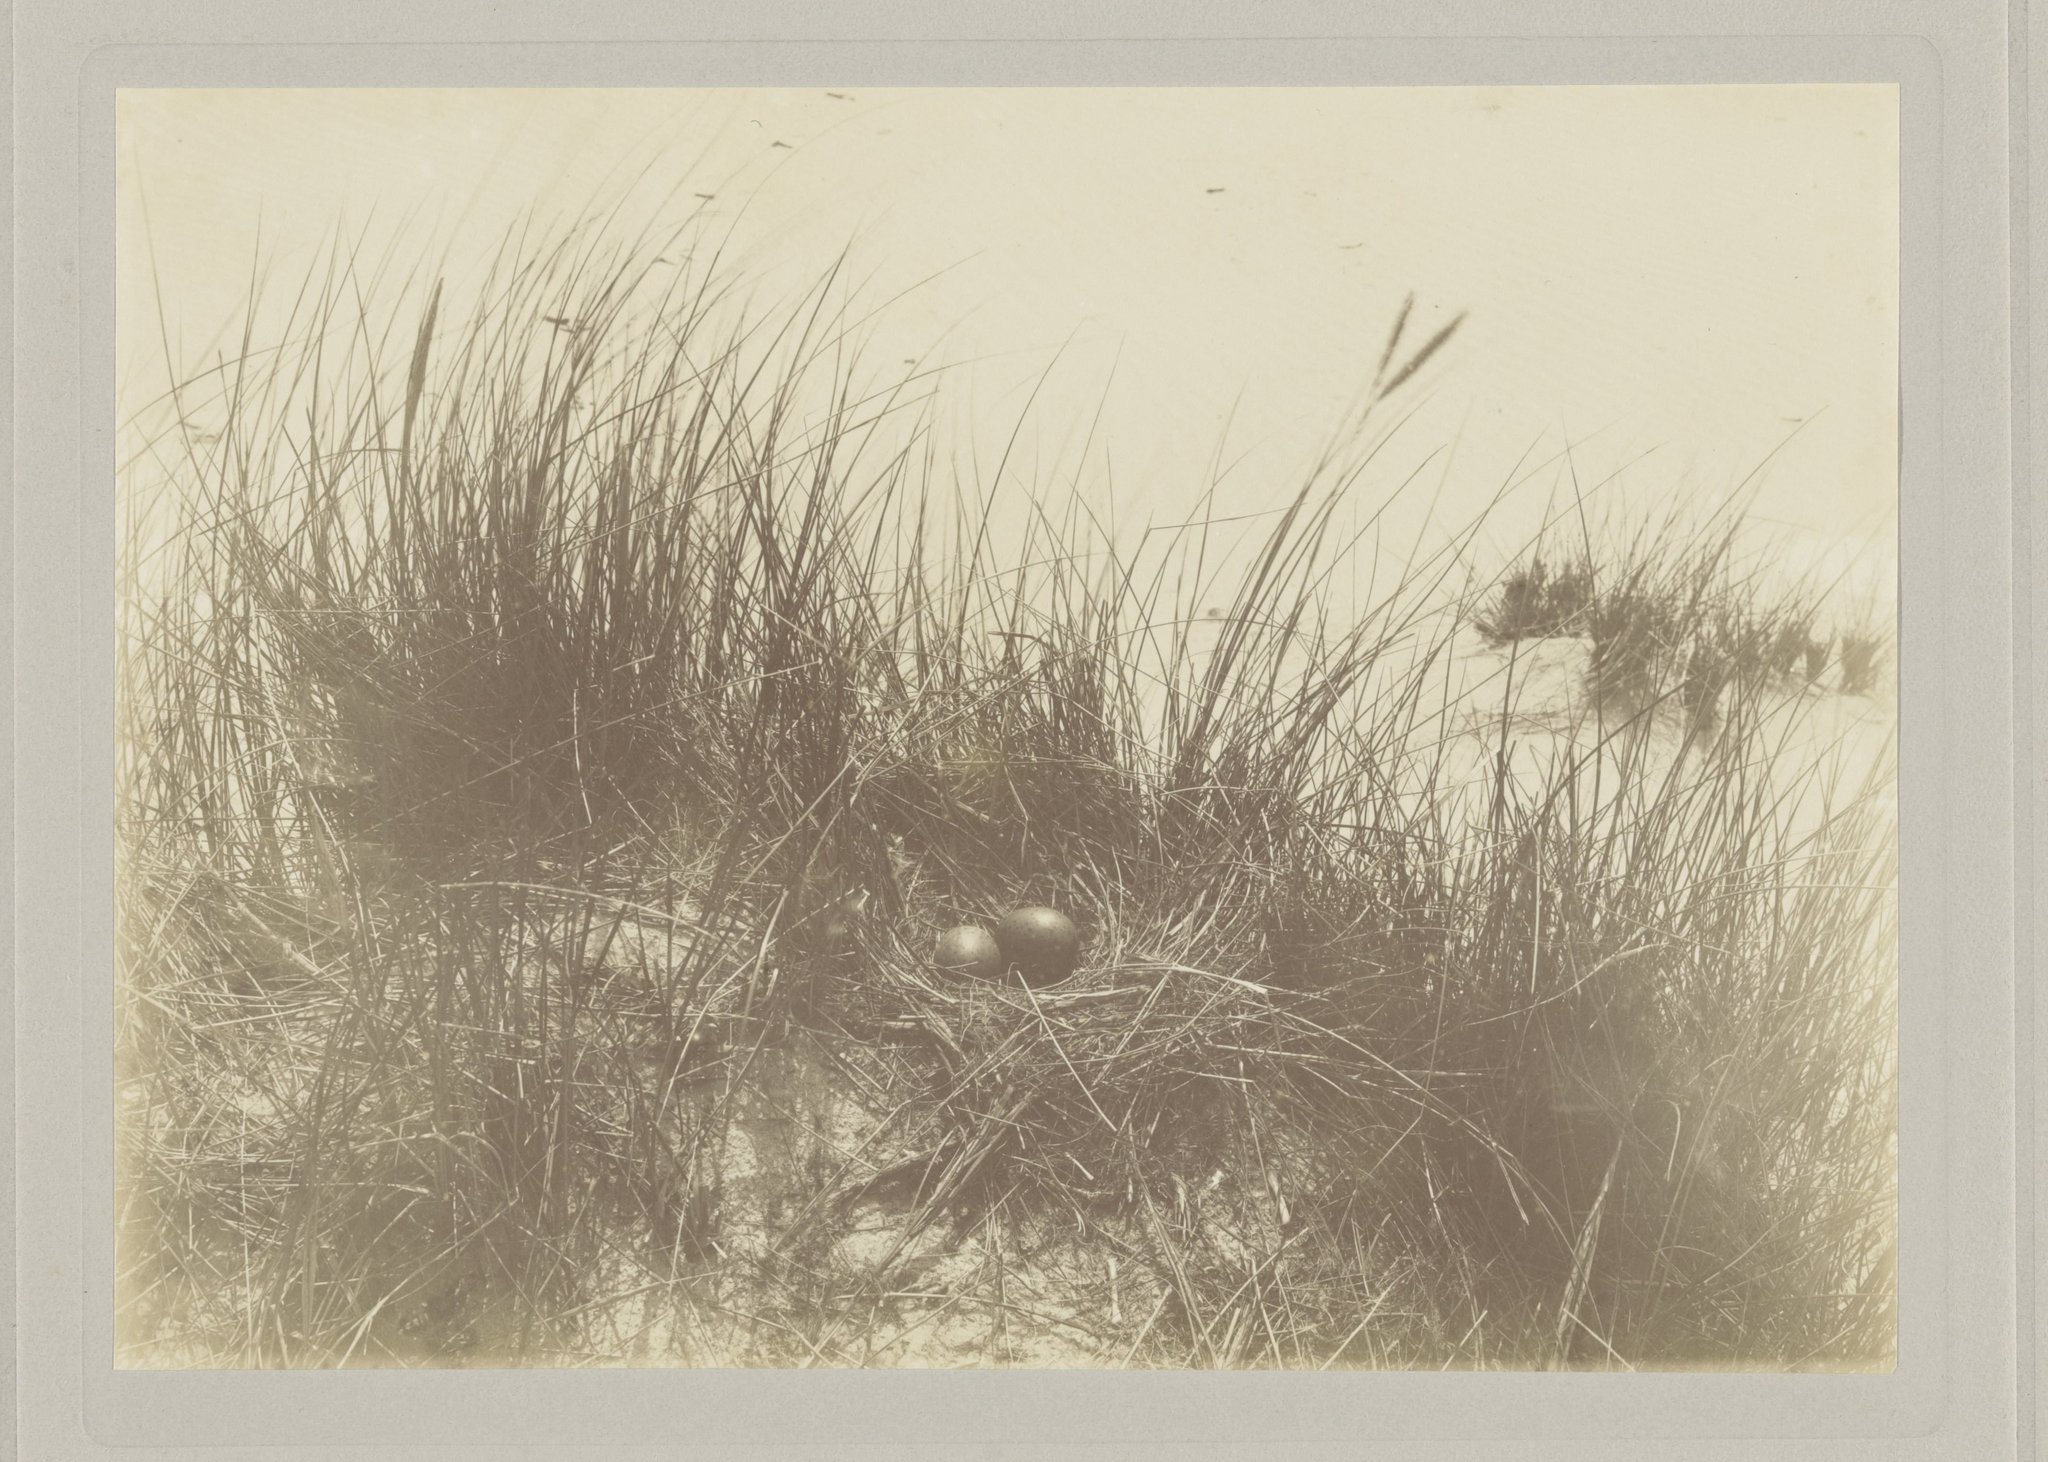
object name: photograph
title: Nest van de zilvermeeuw met eieren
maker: richard tepe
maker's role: fotograaf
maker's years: 1864-1952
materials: cardboard, paper, photographic support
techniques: albumen print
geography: netherlands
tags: nesting-box (+ variant)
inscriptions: inscription: ‘[uitgebreid, zie foto]’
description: Pl. III uit serie/portefeuille ? 'Nest met eieren van de Zilvermeeuw, zie fondslijst Stins PZ Bloemendaal; afgebeeld in Thijsse het Vogeljaar 2de ed. 1913, p. 371